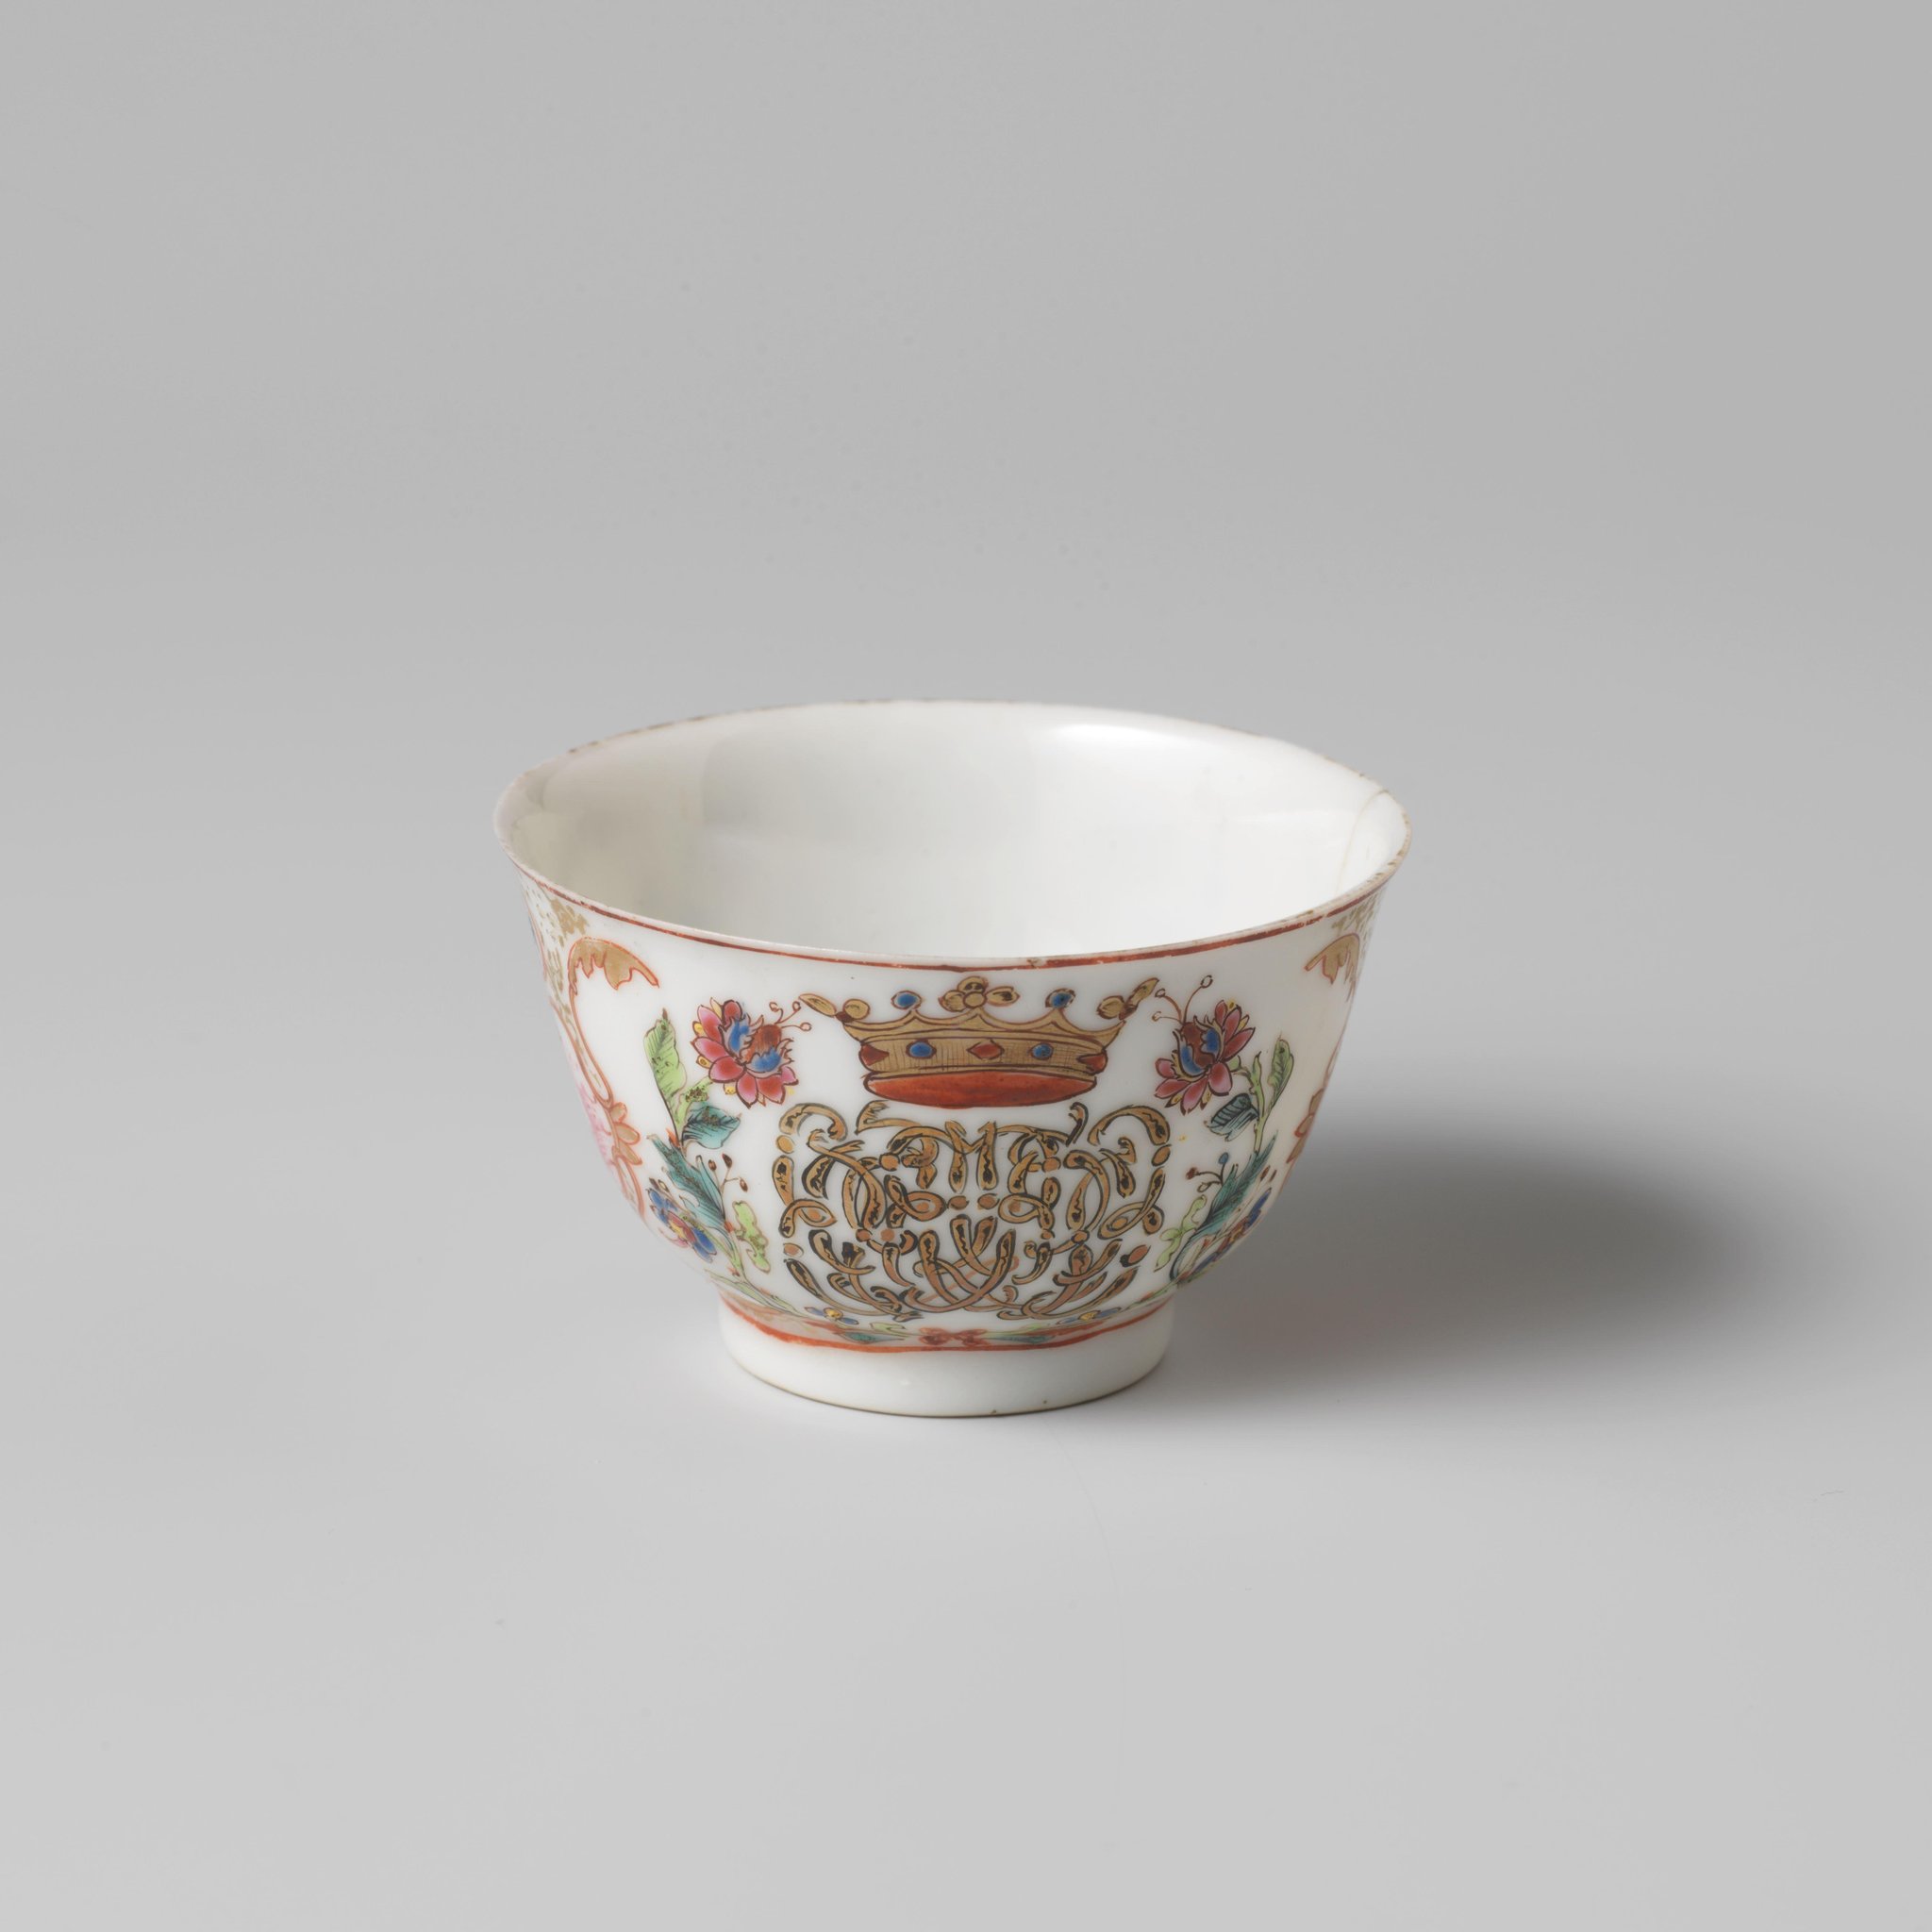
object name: cup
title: Bell-shaped cup with a crowned, illegible monogram surrounded by two flower sprays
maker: Anonymous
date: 1750-1774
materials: glaze, gold, paint, porcelain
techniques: firing, gilding, turning, vitrification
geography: china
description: Klokvormige kop van porselein, beschilderd op het glazuur in blauw, rood, roze, groen, geel, zwart en goud. Op de buitenwand tweemaal een gekroond, onleesbaar monogram omringd door twee bloemtakken; hiertussen bloemranken met daarin uitgespaard twee cartouches met een landschap en vier medaillons met planten. Een barst in de wand. Europese voorstelling in emailkleuren.